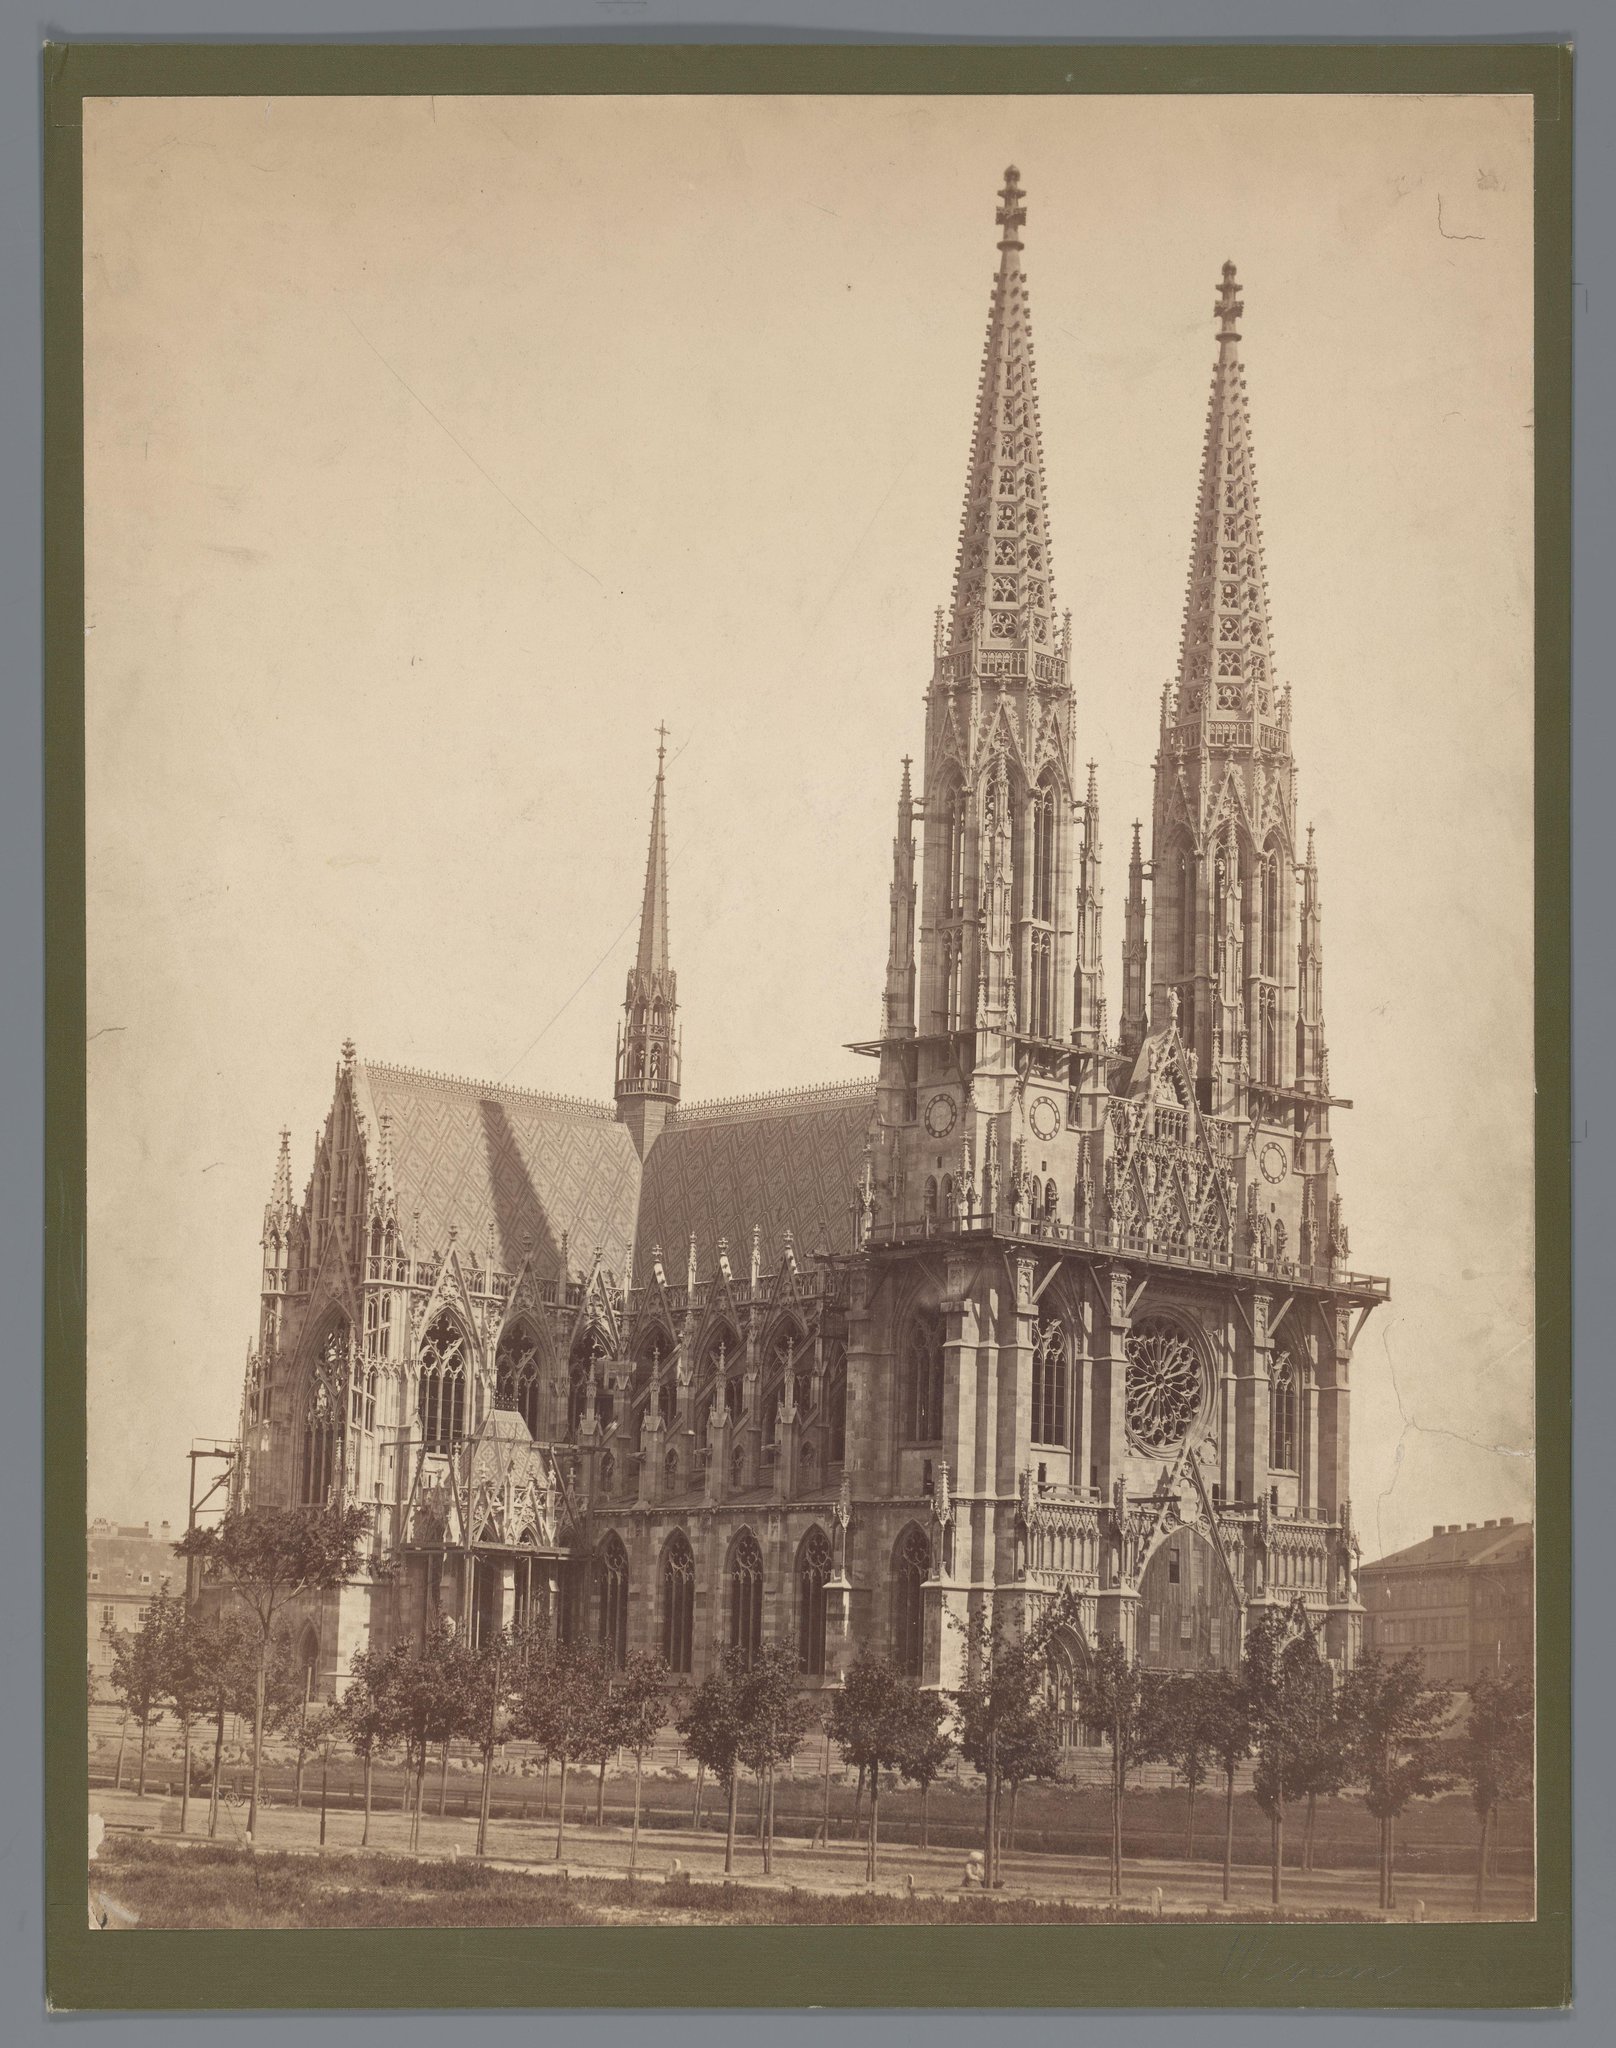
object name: photograph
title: Exterieur van de Votivkerk in Wenen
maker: Anonymous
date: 1879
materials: cardboard, linen, paper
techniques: albumen print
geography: vienna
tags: church (exterior)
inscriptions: collector's mark: ‘RIJKSSCHOOL VOOR KUNSTNIJVERHEID/ GROEP’